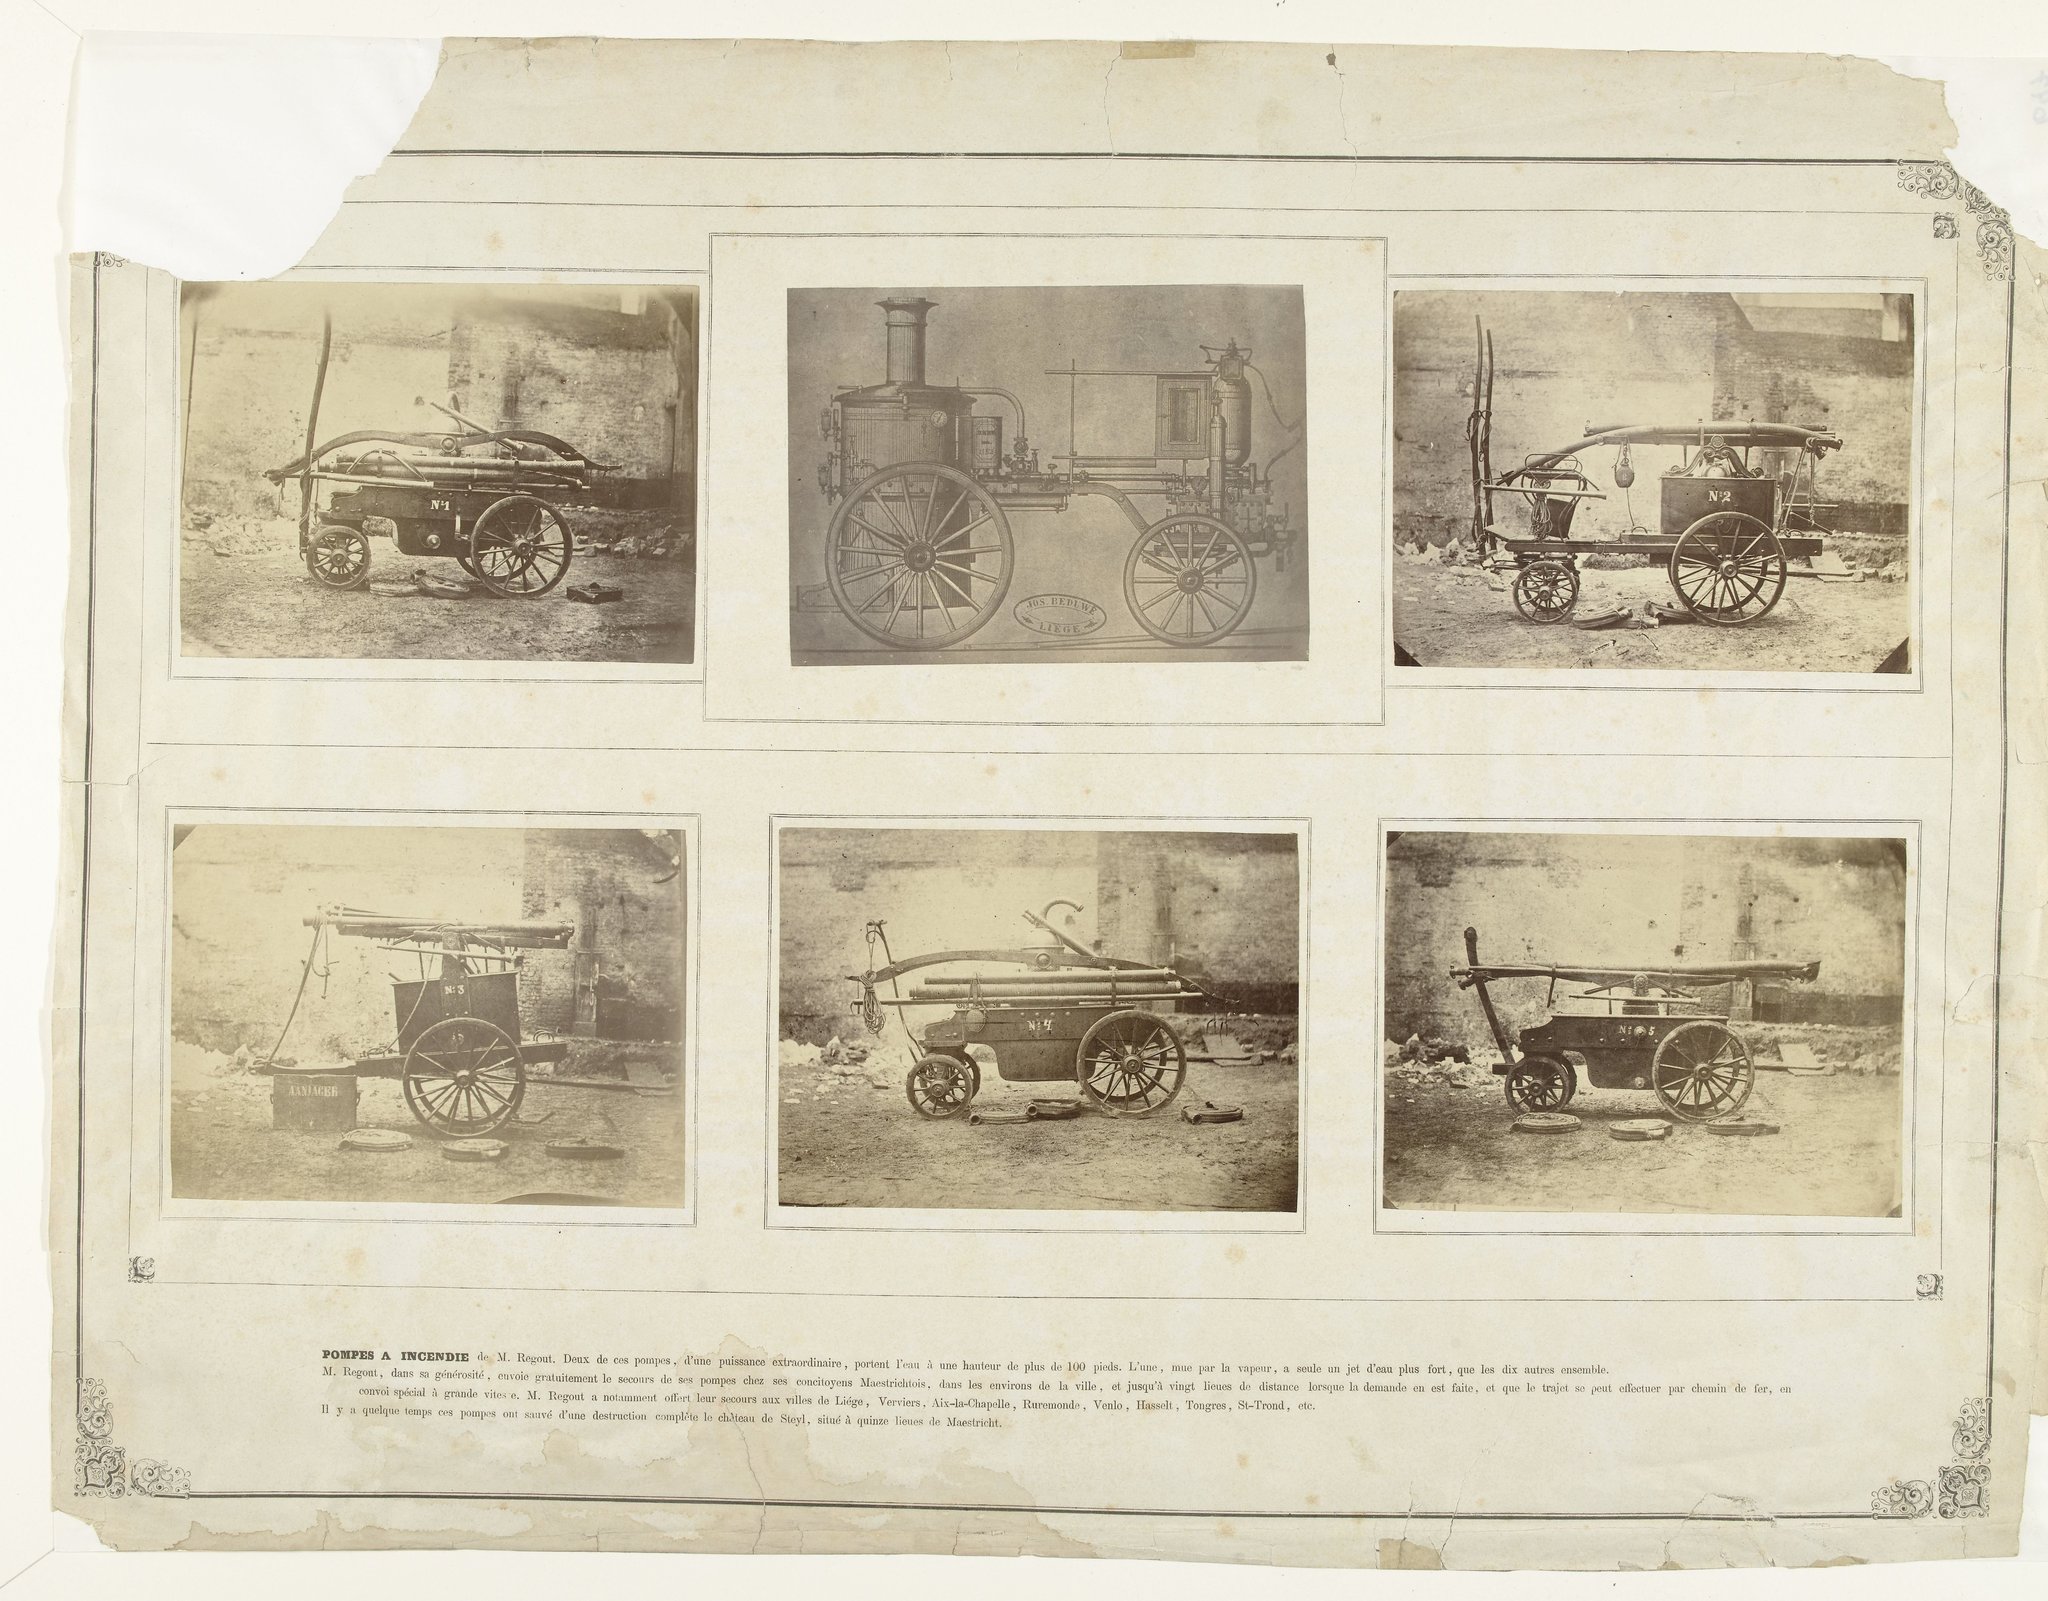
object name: album leaf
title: Blad uit Album dedié à mes enfants et mes amis (1868) met opgeplakte foto's van brandspuiten van de firma's Regout en Beduwe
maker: Anonymous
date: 1868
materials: cardboard, photographic support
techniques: albumen print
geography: maastricht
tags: fire-extinguishing equipment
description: Brandspuit nummer 3 van de firma Regout op een blad met foto's van nog vijf andere brandspuiten afkomstig uit een album. Franse tekst onderaan het blad beschrijft de brandspuiten en de voordelen van het gebruik.